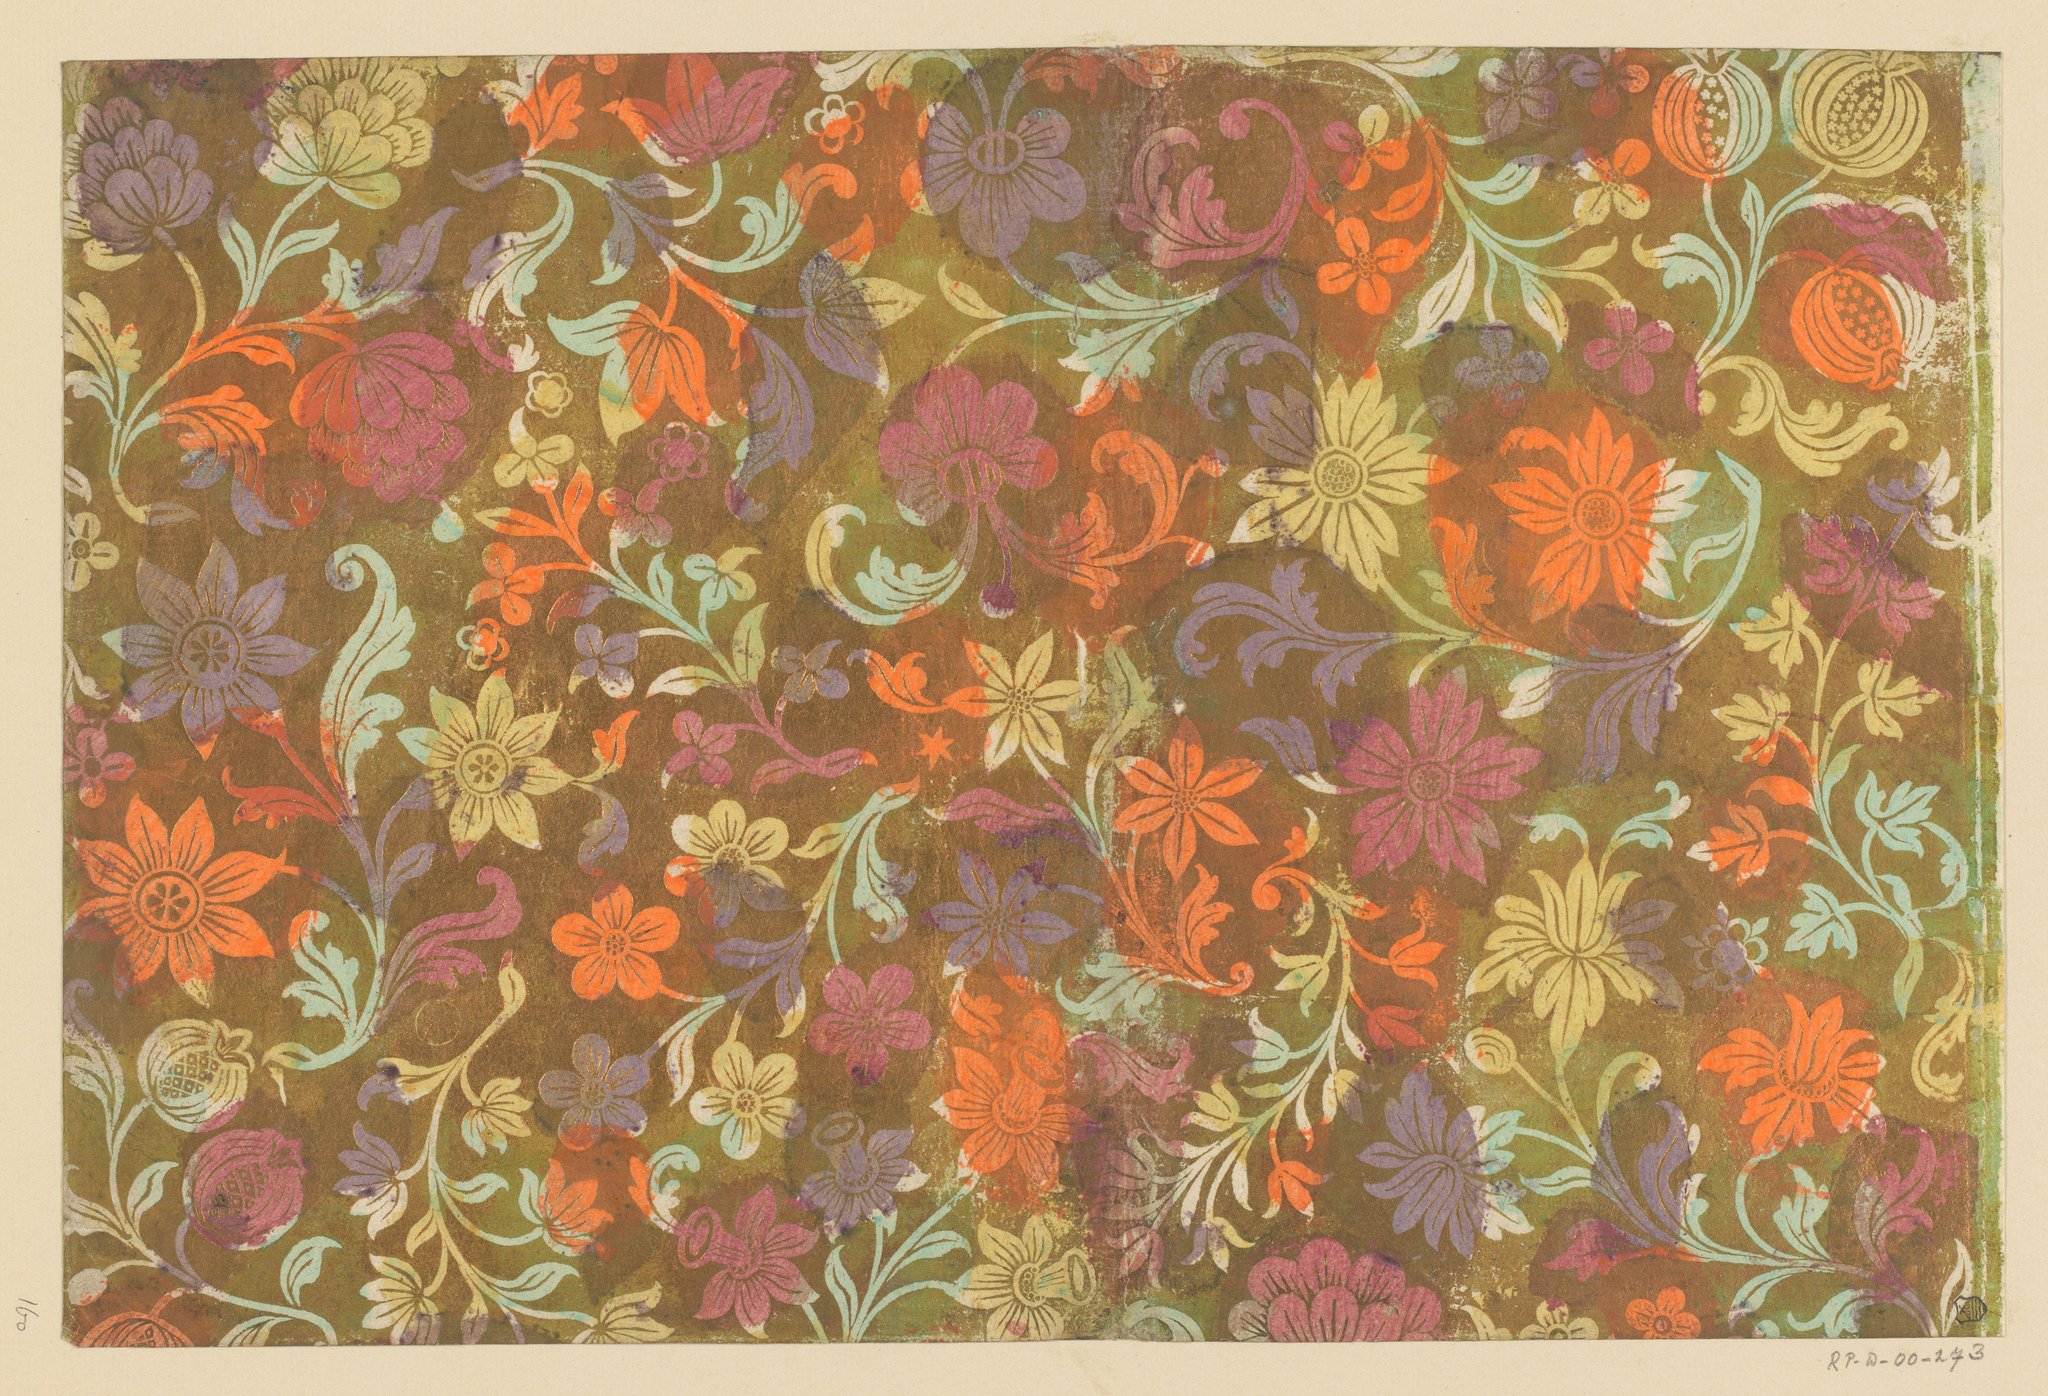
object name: brocade paper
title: Blad met bloemen en vruchten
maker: johann michael munck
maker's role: ontwerper sierpapier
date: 1730-1760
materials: gold leaf, paint, paper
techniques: relief print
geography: augsburg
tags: ornament derived from plant forms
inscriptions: collector's mark: Lugt 2760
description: Blad met bloemen en vruchten, rechtsboven drie granaatappels, linksonder twee granaatappels.